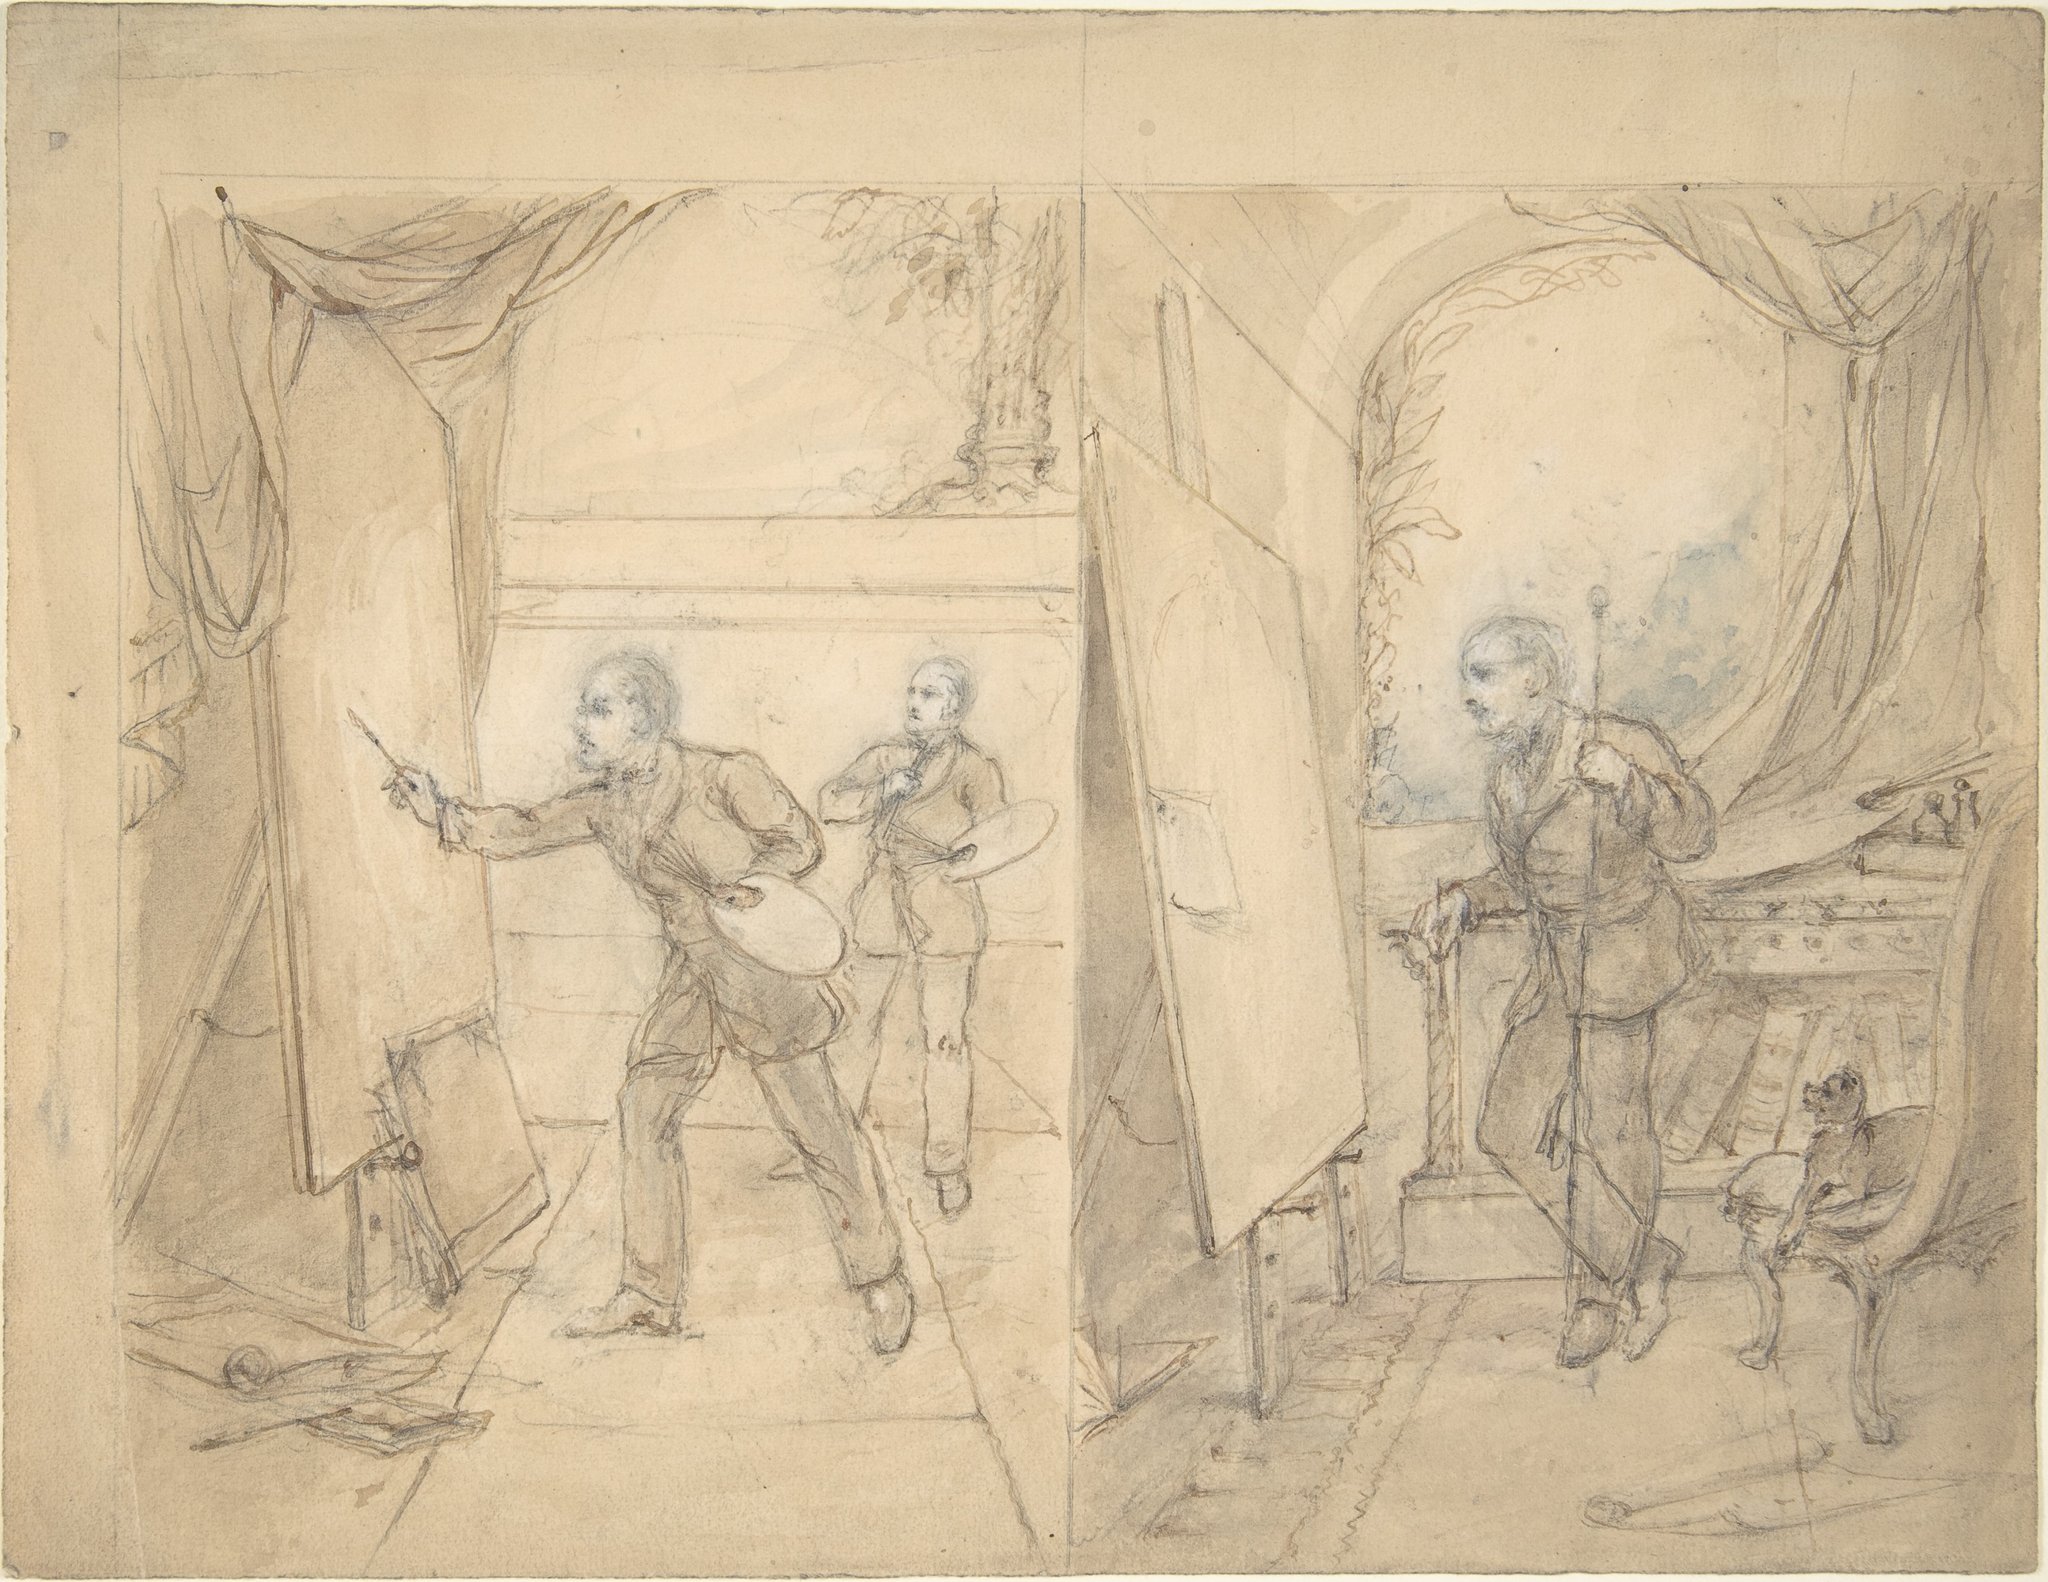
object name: drawing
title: Two Views of an Artist's Studio, possibly that of Eden Upton Eddis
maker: anonymous, british, 19th century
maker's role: artist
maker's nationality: british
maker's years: 1800-1900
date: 1859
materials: chalk, ink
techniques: brush, pen, wash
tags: painting,men,artists